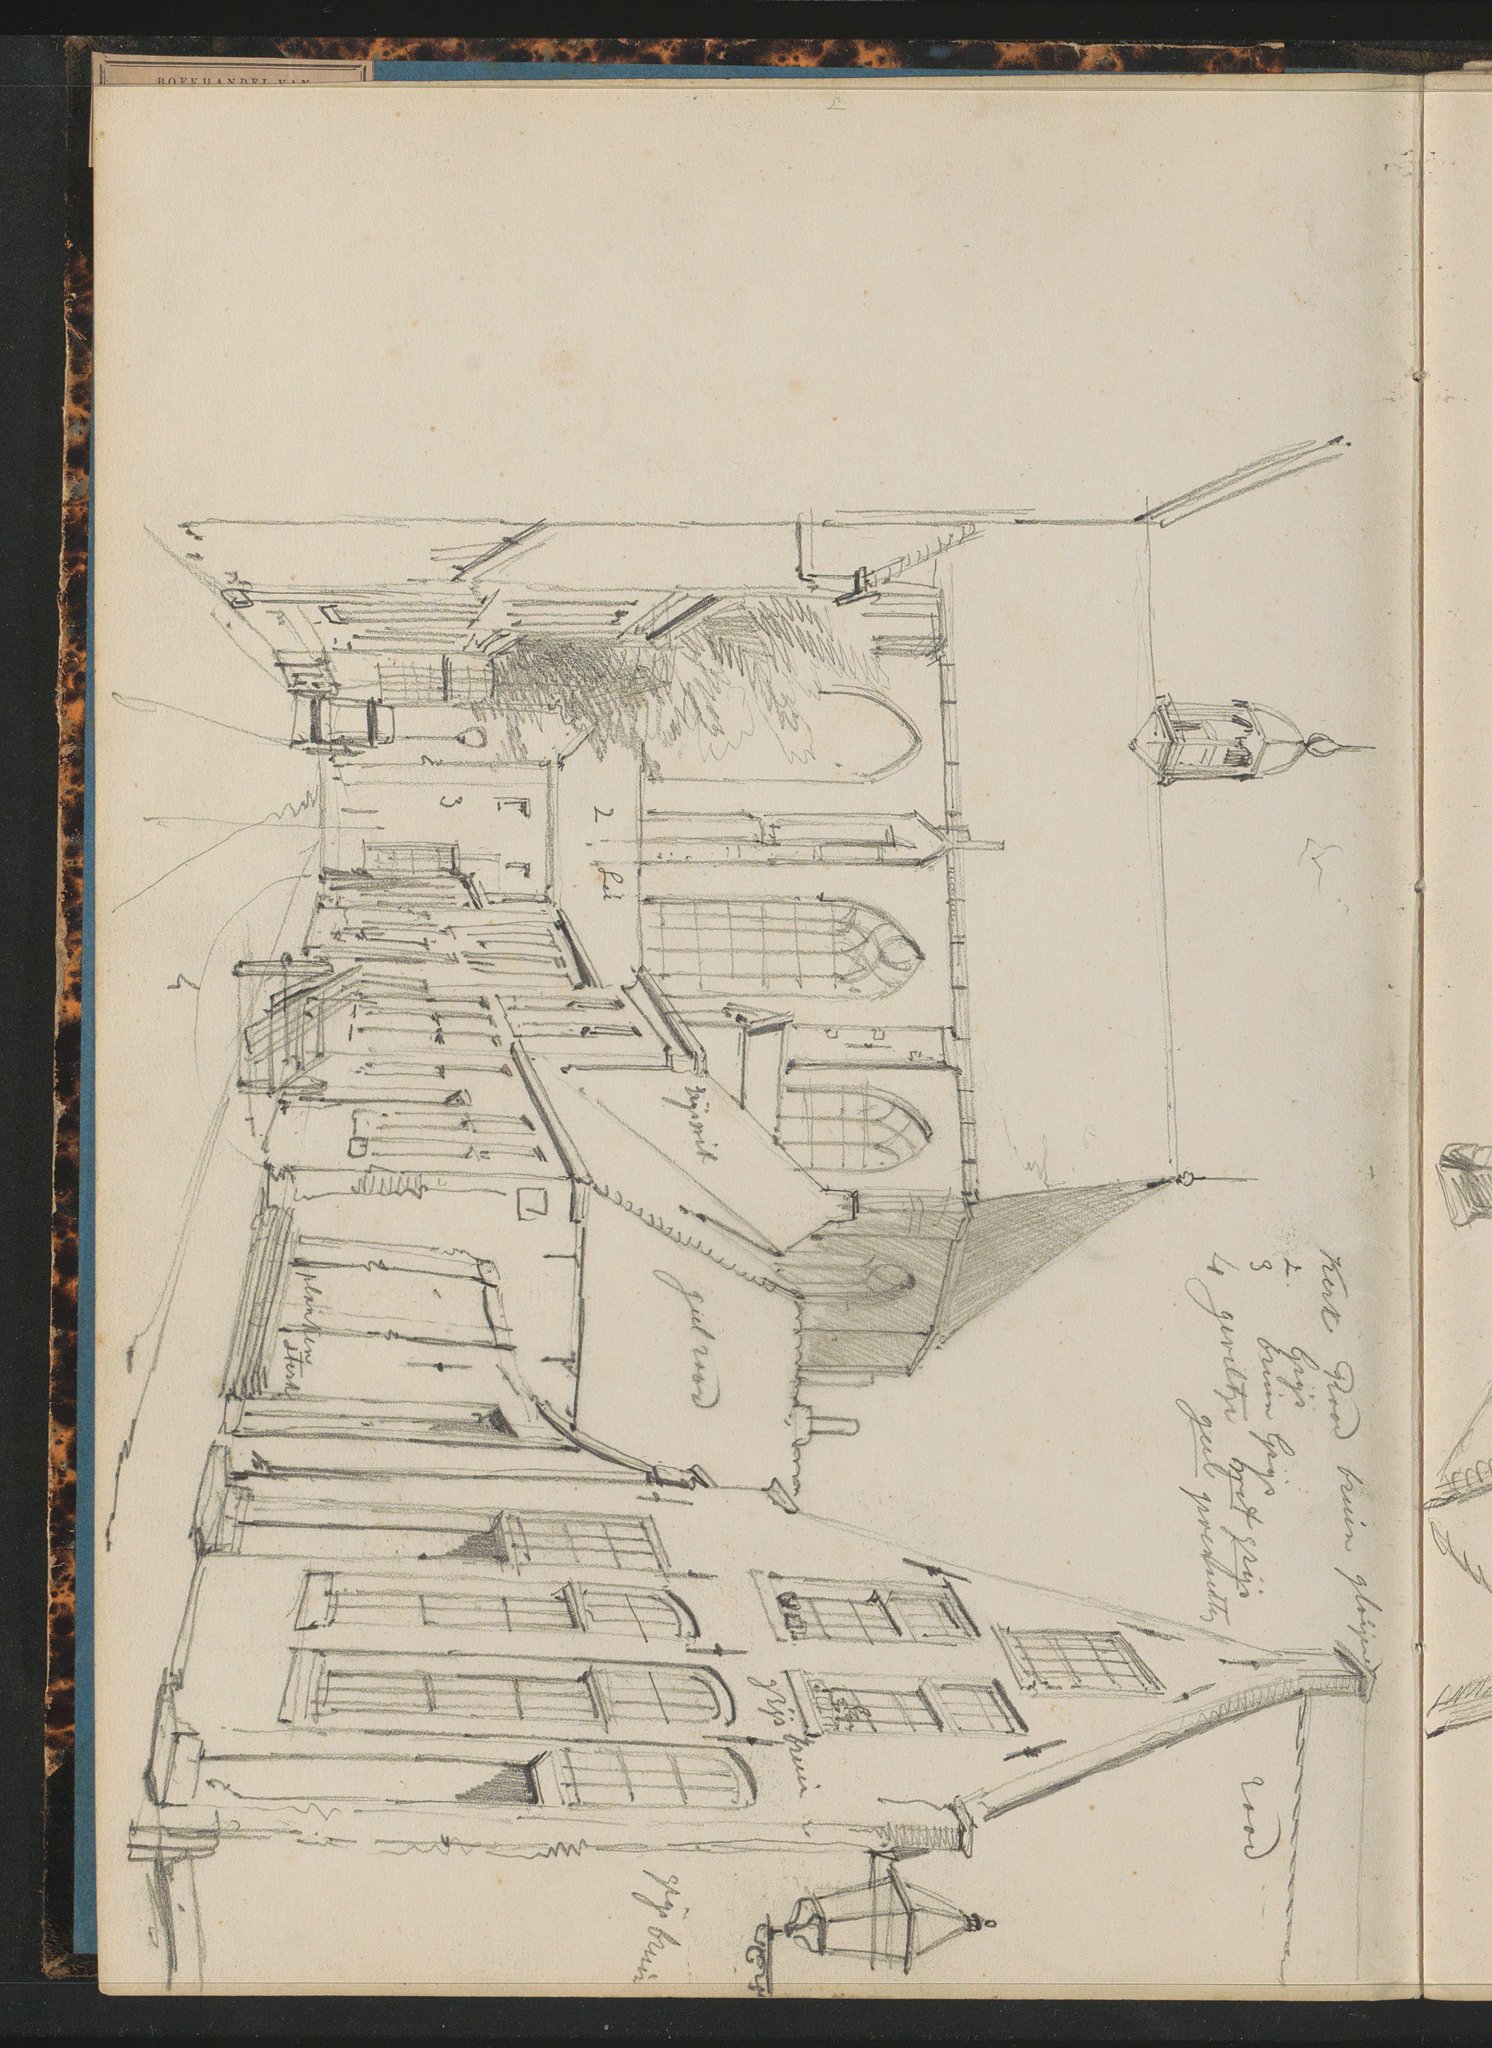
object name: sketchbook leaf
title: Straat uitkomend op een kerk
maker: willem koekkoek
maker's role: draughtsman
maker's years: 1839-1895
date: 1888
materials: paper, pencil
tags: village street, church (exterior)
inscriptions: kleurnotitie, handgeschreven in potlood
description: Blad 1 verso uit een schetsboek met 24 bladen.